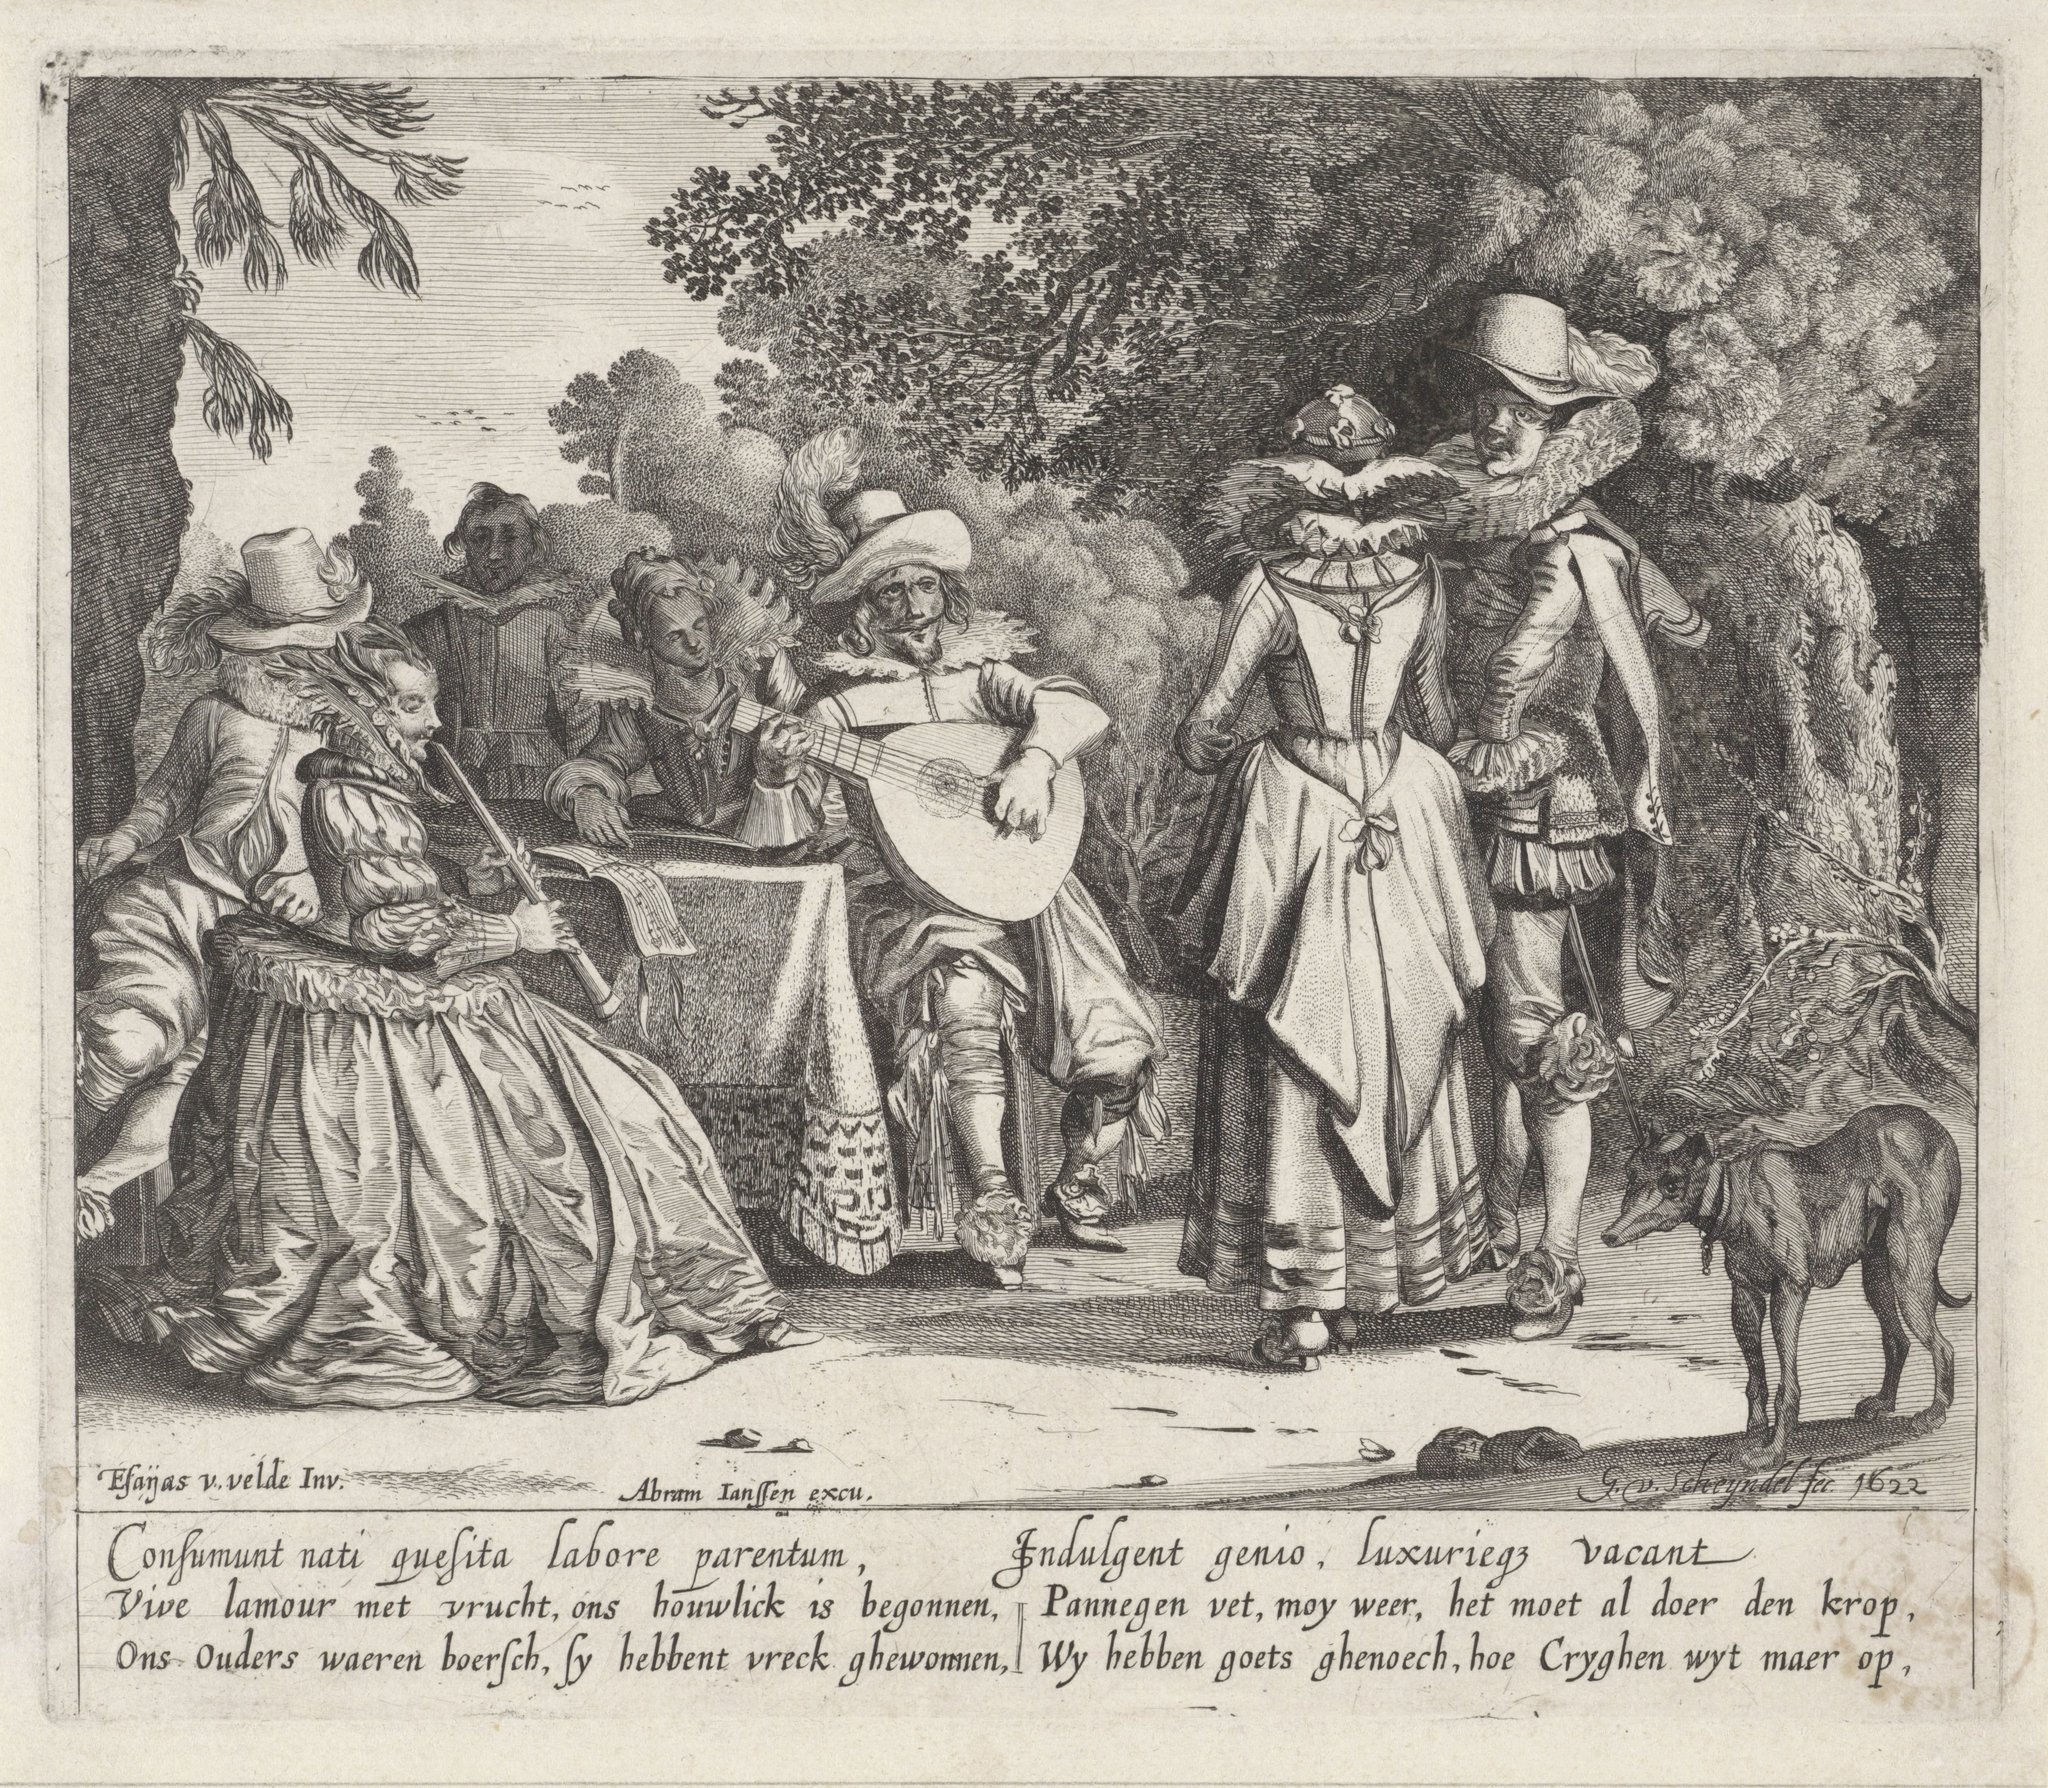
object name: print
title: Musicerend elegant gezelschap in de openlucht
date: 1622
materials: paper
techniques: engraving, etching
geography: netherlands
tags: transverse flute - cc - out of doors, neck-gear ~ clothing (with name) (+ men's clothes), dress, gown (fartingale) (+ women's clothes), skirt (underskirt) (+ women's clothes), head-gear: hat (+ men's clothes), neck-gear: collar (+ women's clothes), clothes, costume (+ women's clothes), skirt (+ women's clothes), more than one musician with instrument - cc - 'concert champêtre', clothes, costume (+ men's clothes), outdoor gathering, 'délices à la campagne', trousers, breeches, etc. (breeches) (+ men's clothes), clothing for the upper part of the body (doublet) (+ men's clothes), clothing for the upper part of the body (with name) (+ women's clothes), lute, and special forms of lute, e.g.: theorbo - cc - out of doors, netherlands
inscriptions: signature: ‘Esaias v. velde Inv.’, address: ‘Abram Ianssen excu.’, collector's mark: Lugt 240, caption: ‘Consumunt nati quesita labore parentum, Indulgent genio, luxurieq_ vacant.’, caption: ‘Vive l'amour met vrucht, ons houwlick is begonnen / Ons Ouders waeren boersch, sy hebbent vreck ghewonnen, / Pannegen vet, moy weer, het moet al doer den krop / Wy hebben goets ghenoech, hoe Cryghen wyt maer op.’, signature: ‘G.v. Scheyndel fec.’, date: ‘1622’, collector's mark: Lugt 2165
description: Elegant gezelschap, gekleed volgens de mode van ca. 1620, in een prieel. Links een zitten fluitspelende dame en luitspelende heer, bij een tafel waarop een muziekboek. Rechts een staand paar, op de rug gezien. Naast hen een hond.